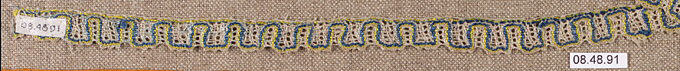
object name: edging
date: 1801-1900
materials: cotton, silk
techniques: lace